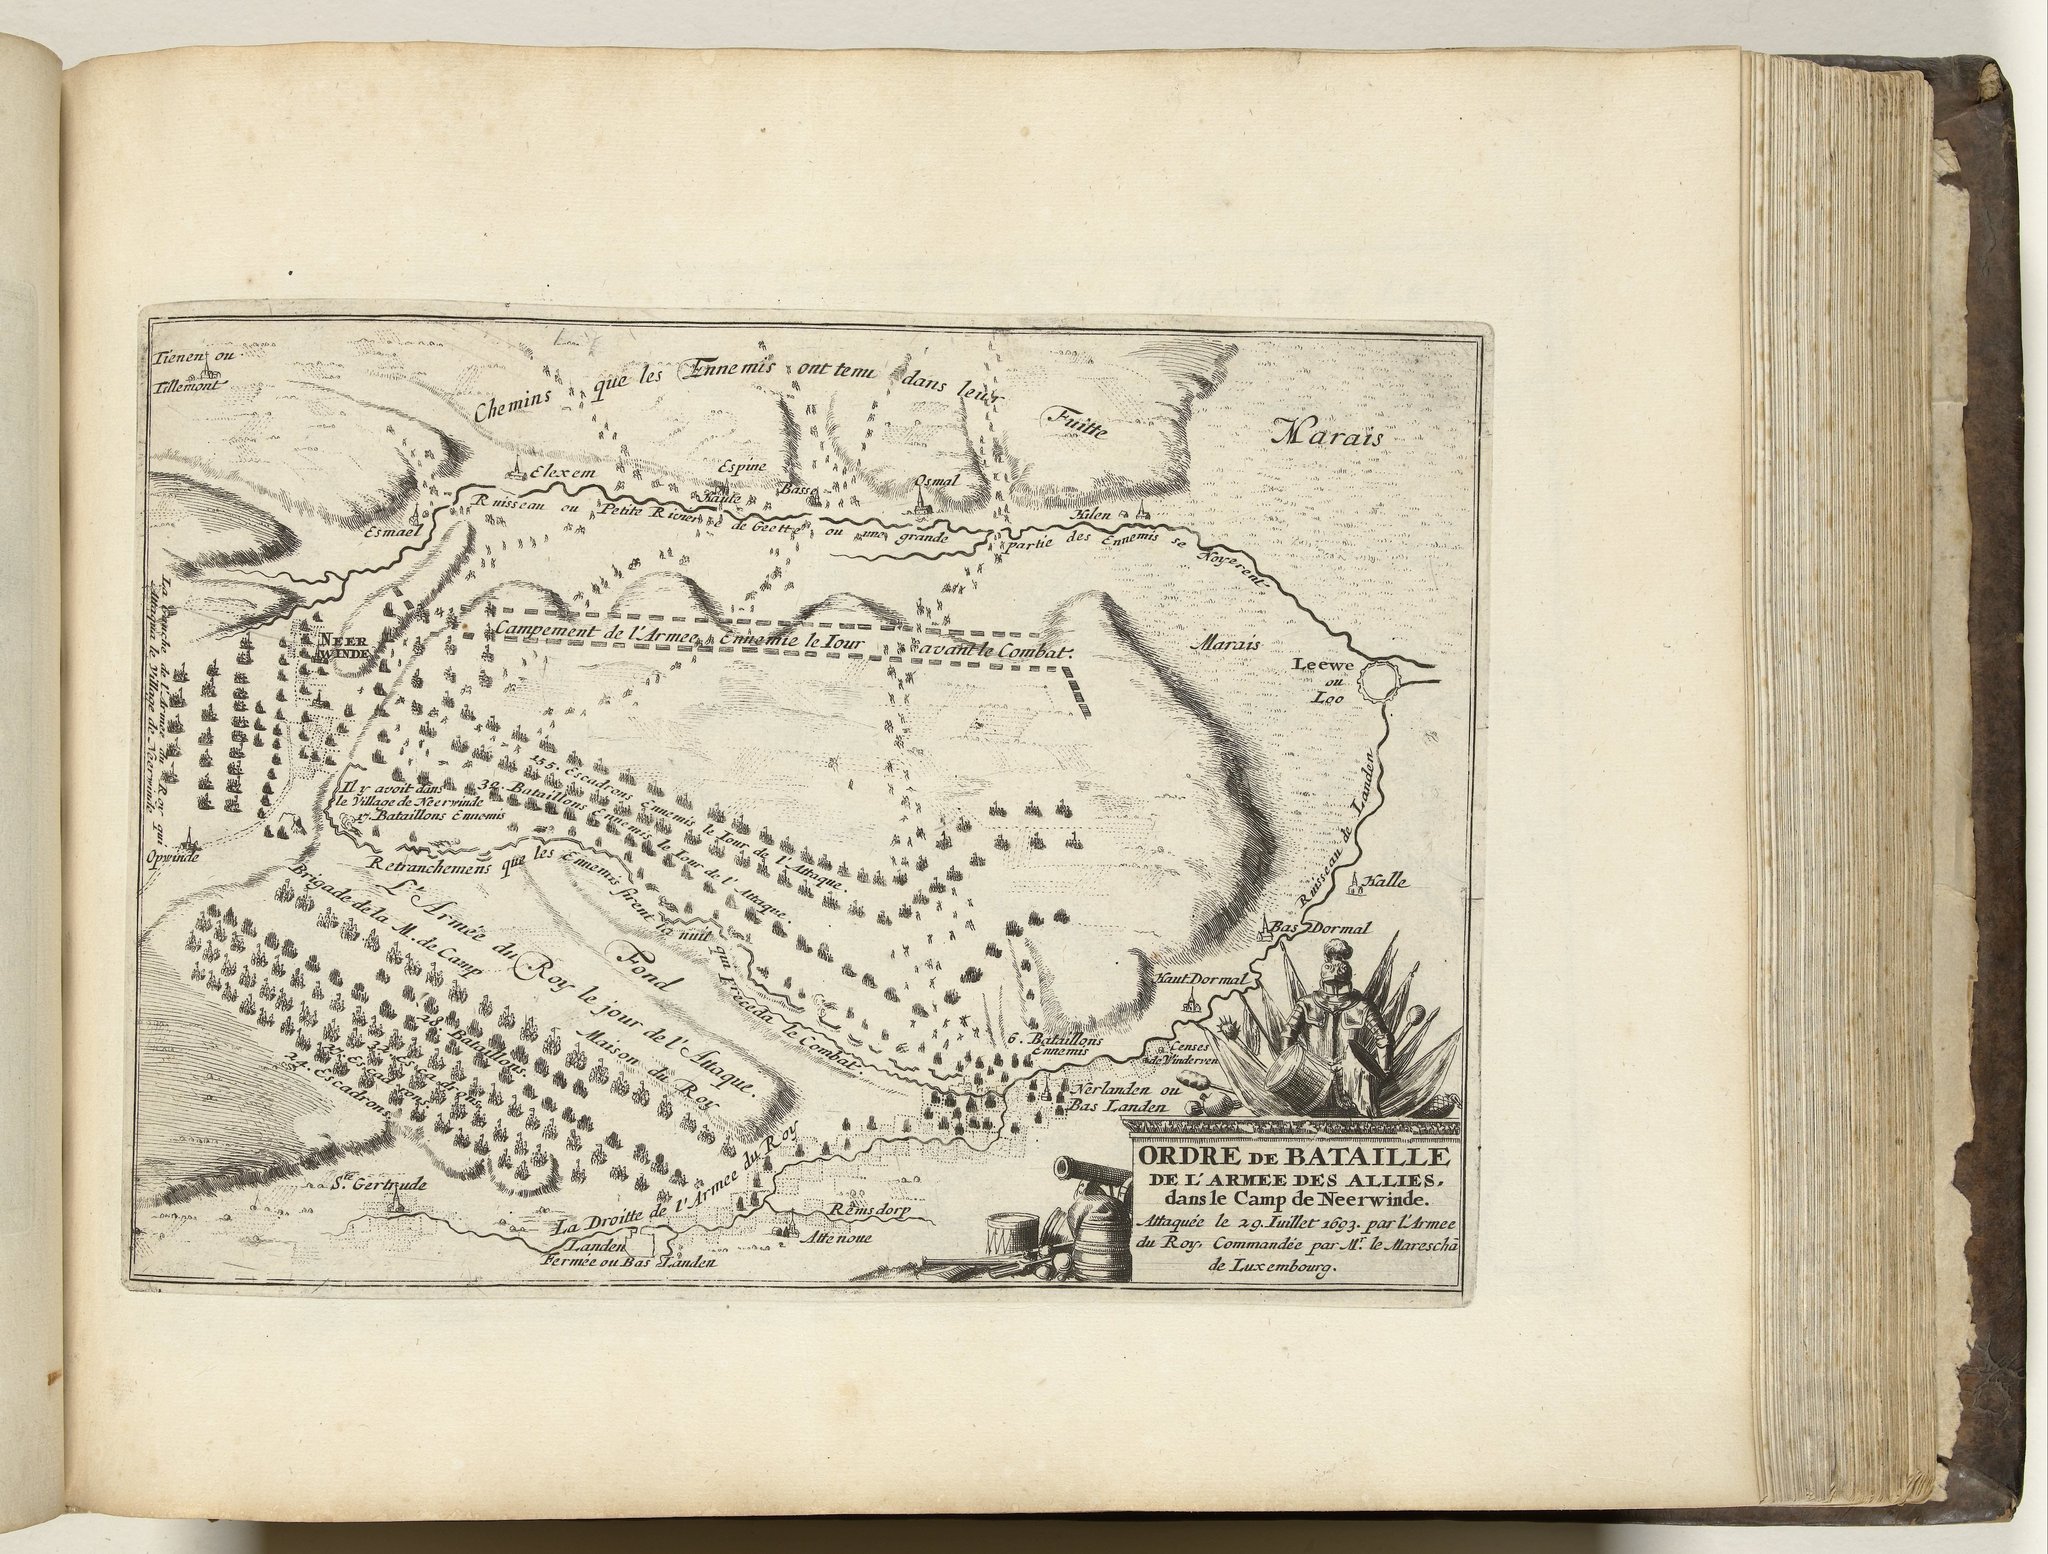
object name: map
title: Ordre de Bataille de l'Armee des Allies dans le Camp de Neerwinde. Attaquée le 29. Juillet 1693 par l'Armée du Roy (...)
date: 1693-1696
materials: paper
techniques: etching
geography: france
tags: maps of separate countries or regions, battle (+ land forces)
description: Plan van de slag bij Landen, ook bekend als de slag bij Neerwinden, waar de geallieerden door het Franse leger verslagen worden, 29 juli 1693. Onderdeel van het vijfde deel (1696) van het prentwerk waarin gebundeld zijn de acht delen van Les forces de l'Europe uitgegeven tussen 1693-1697. Het prentwerk bestaat uit 175 platen met plannen (afkomstig van Sébastien Le Prestre, Seigneur de Vauban) van vermaarde sterke steden en vestingen in de Negenjarige Oorlog. Titel en opschriften in het Frans.